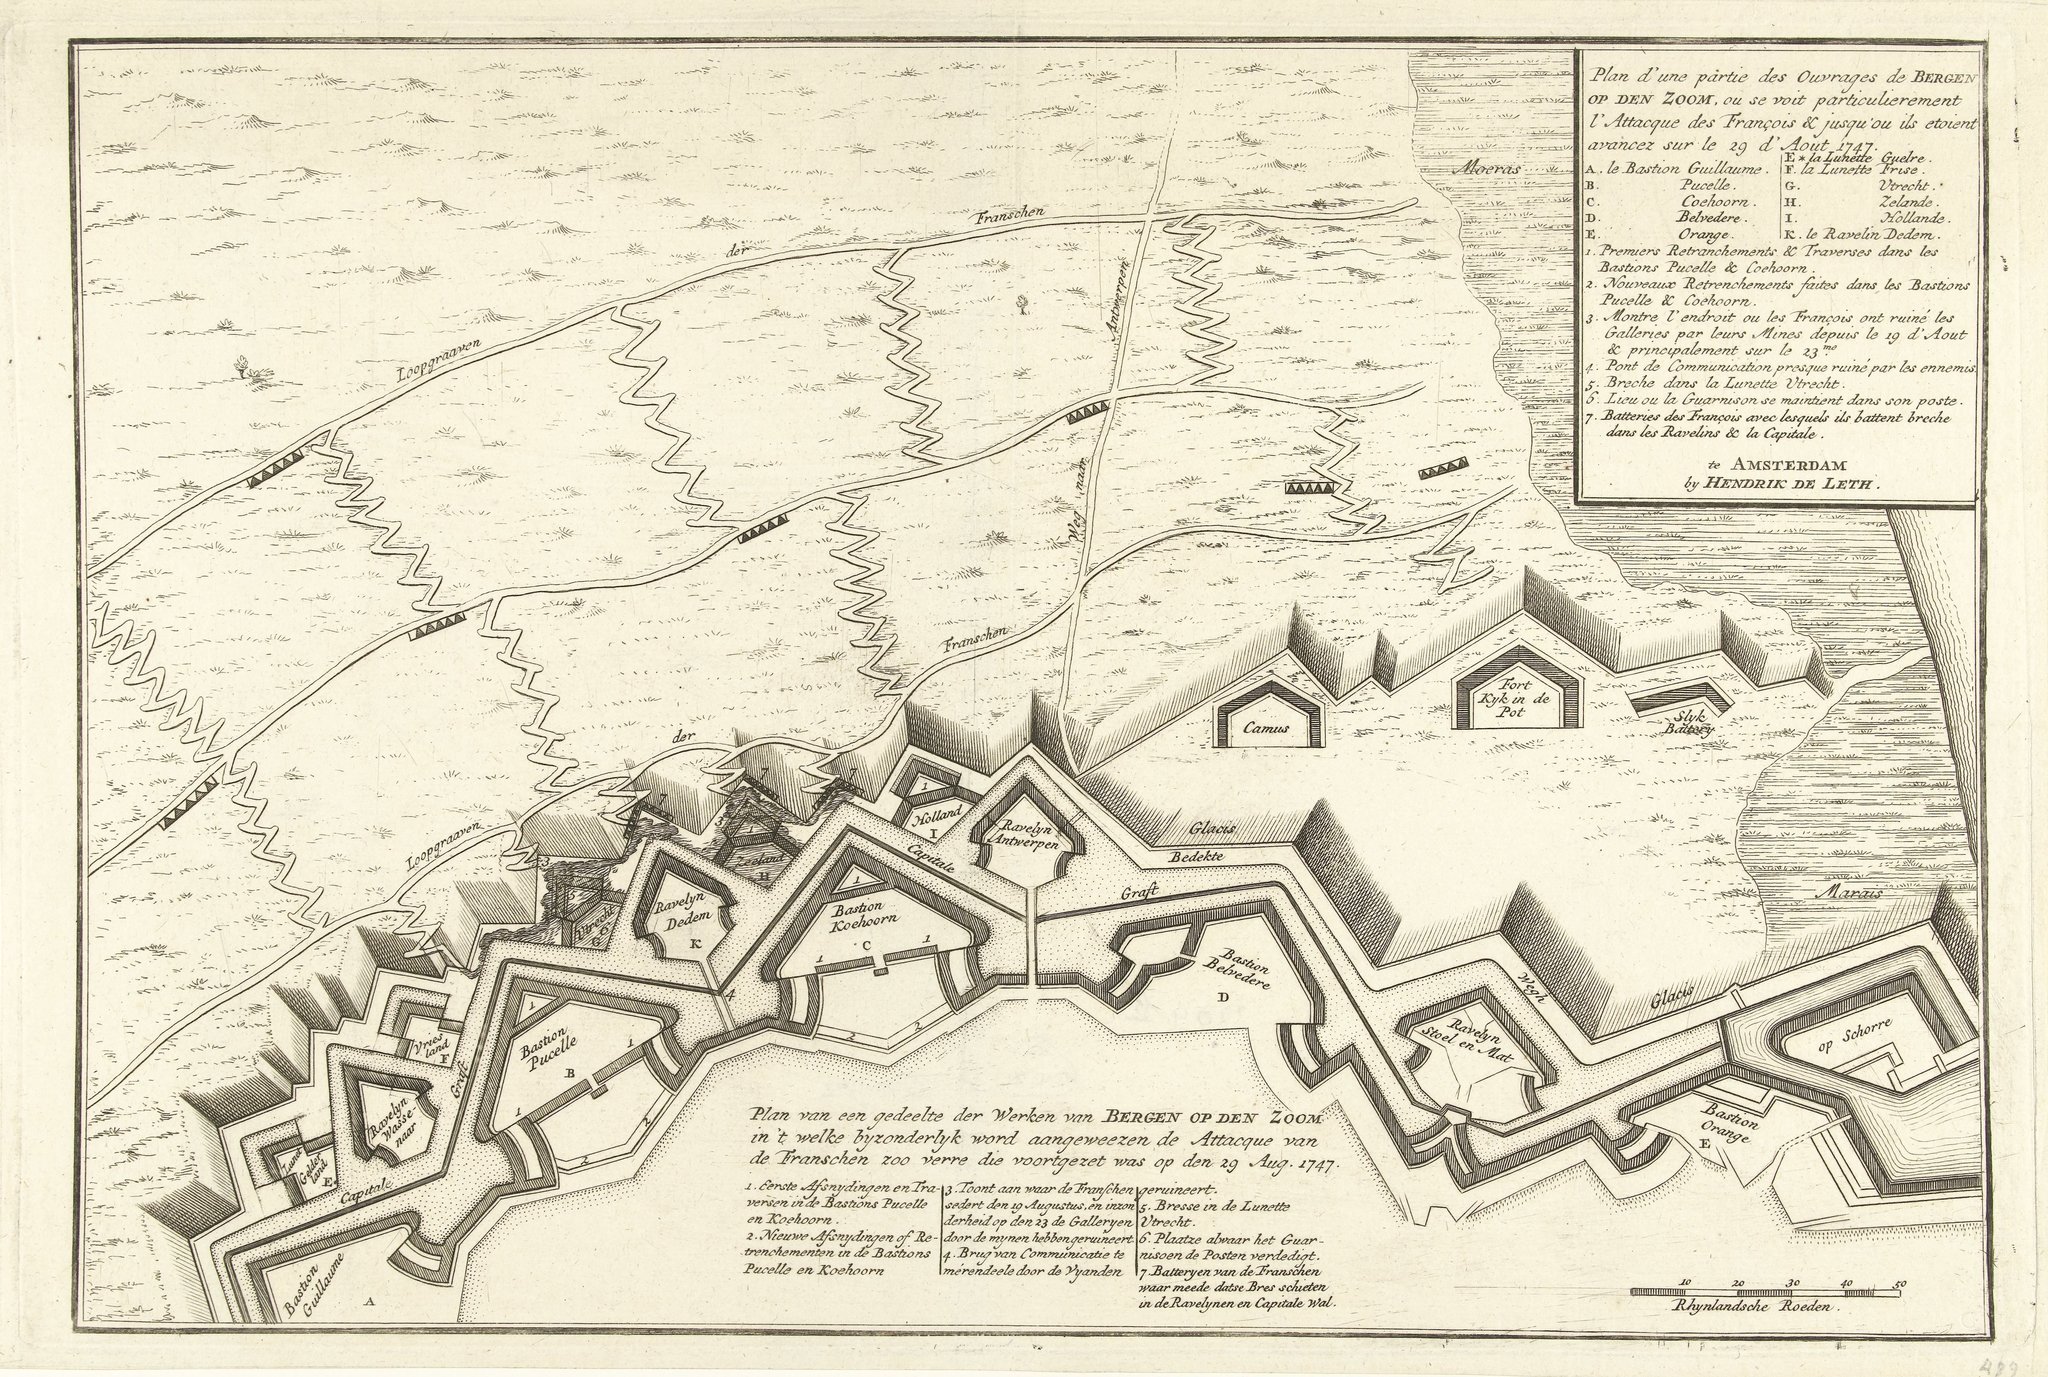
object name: print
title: Plan van een gedeelte der Werken van Bergen op den Zoom in 't welke byzonderlyk word aangeweezen de Attacque van de Franschen zoo verre die voortgezet was op den 29 Aug. 1747 / Plan d'une partie des Ouvrages de Bergen op den Zoom (...)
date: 1747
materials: paper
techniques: engraving, etching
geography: northern netherlands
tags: fortress, bergen op zoom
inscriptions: collector's mark: Lugt 2228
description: Plattegrond van een deel van de verdedigingswerken met de bastions, ravelijnen en lunetten van Bergen op Zoom, met de locatie van de Franse aanval op 29 augustus 1747.